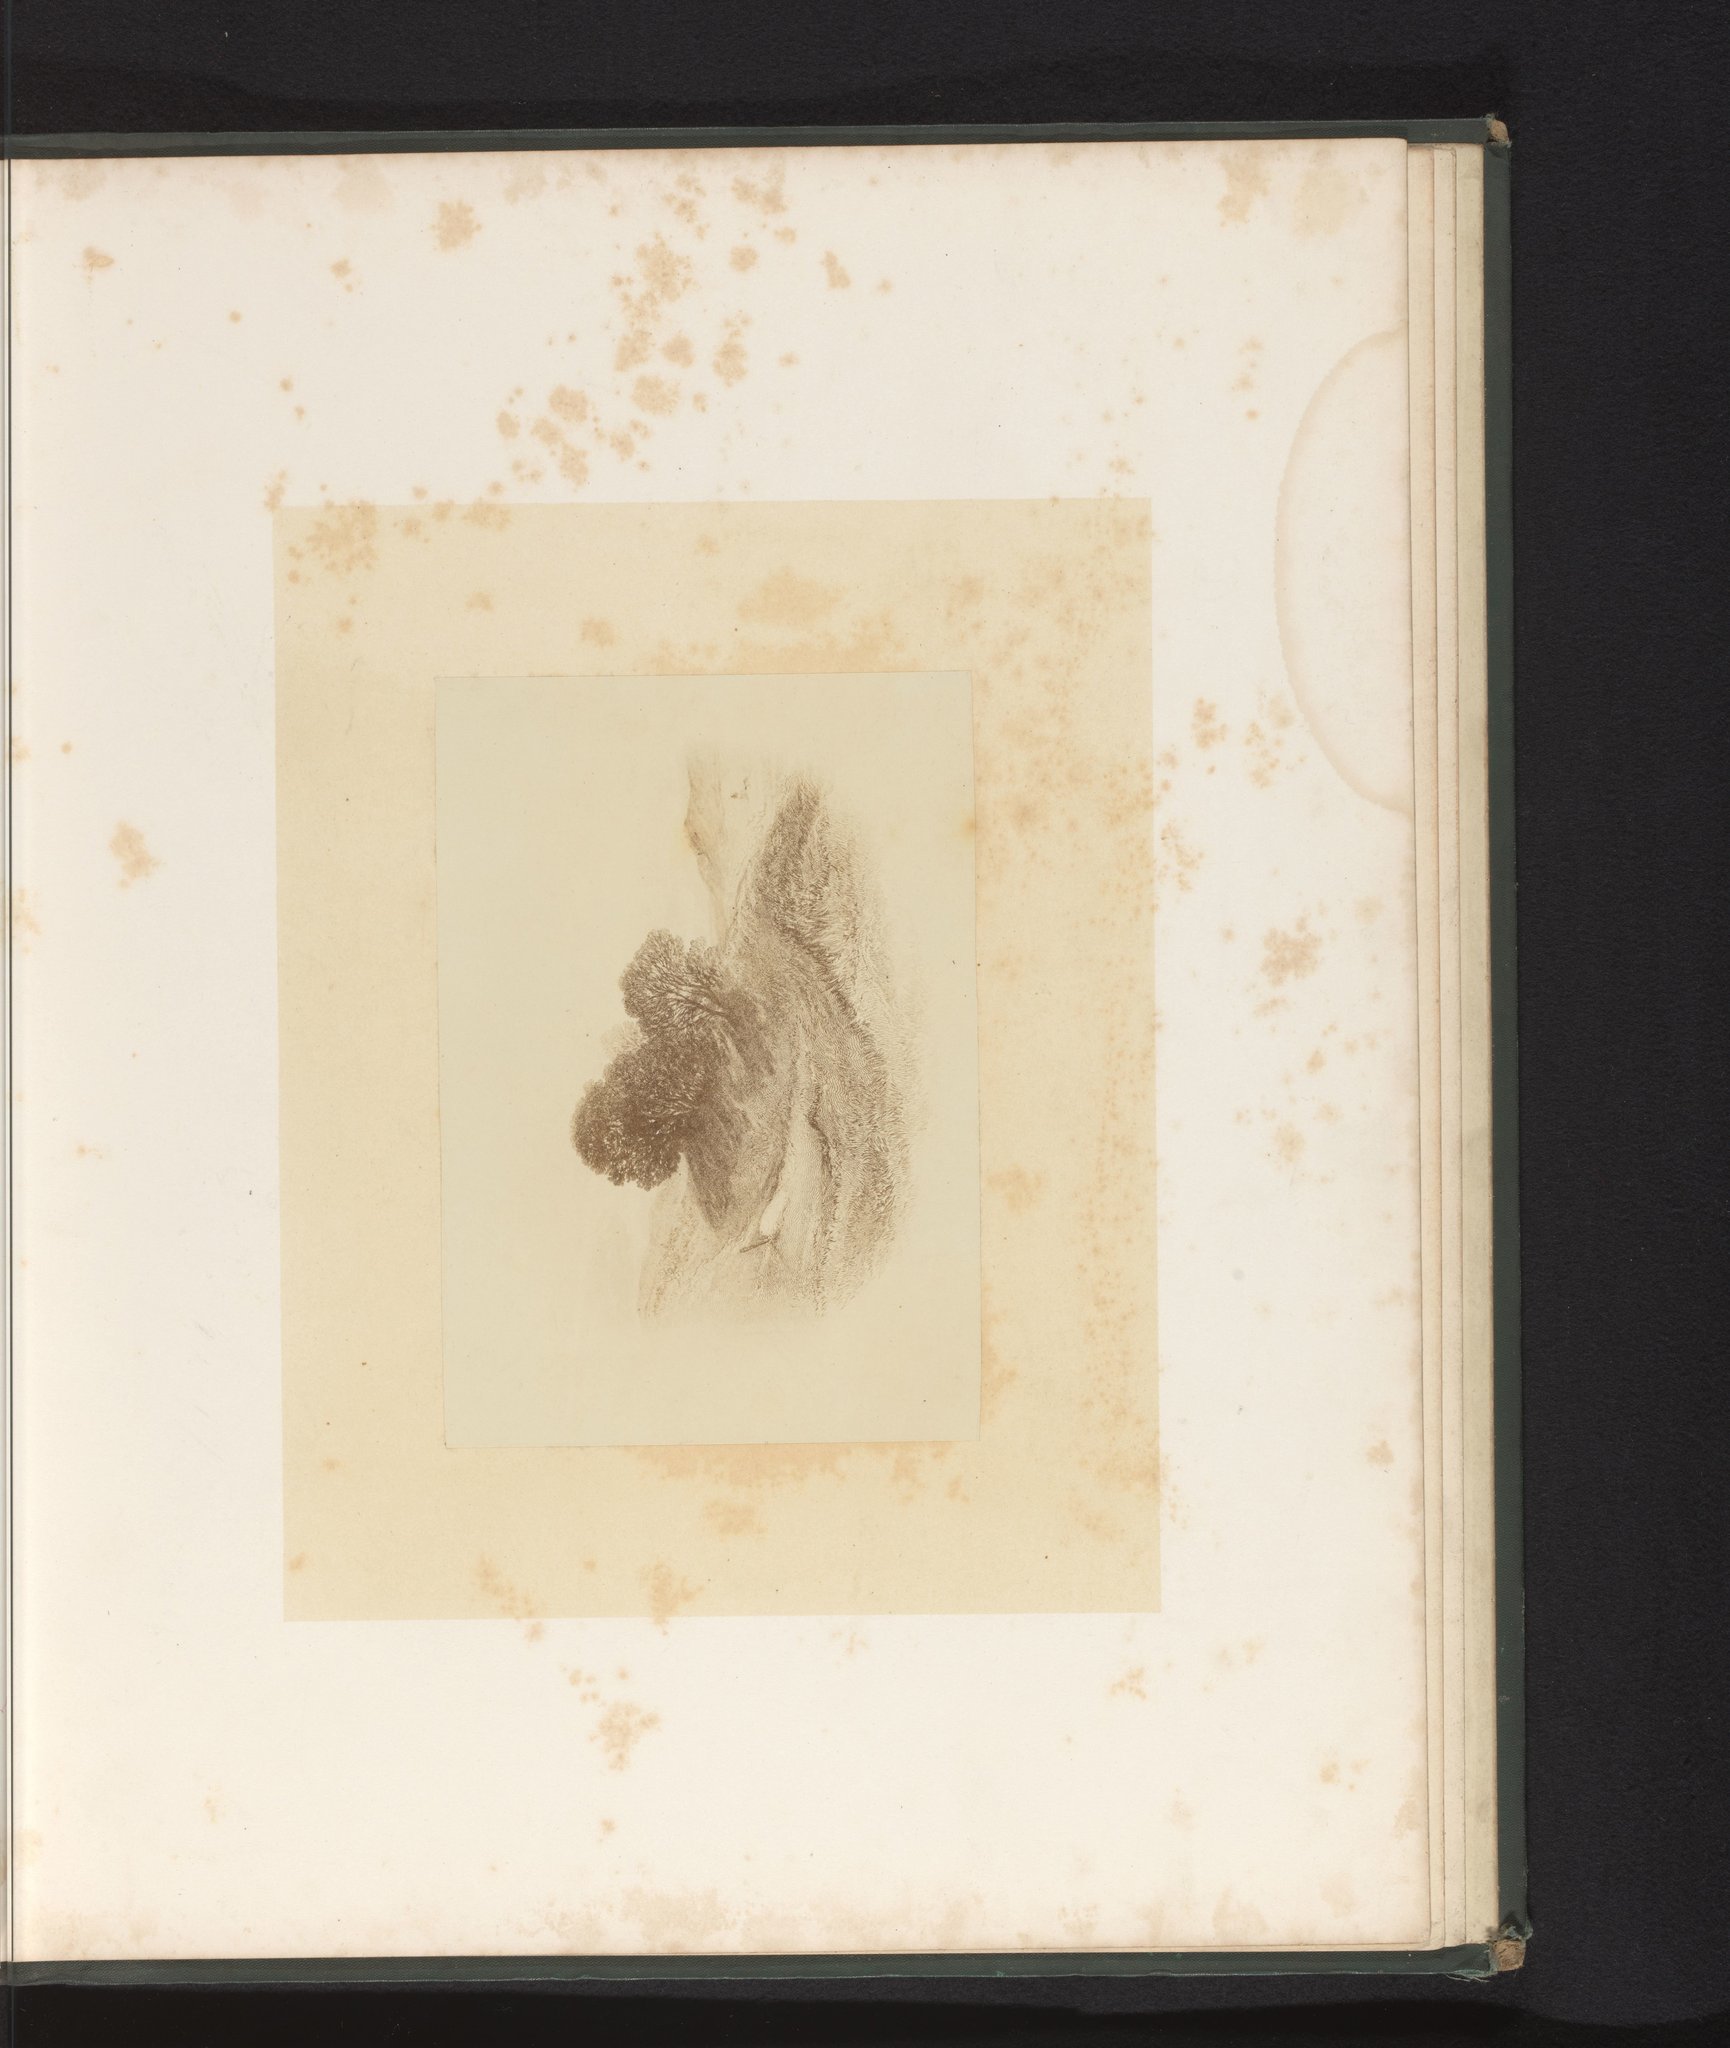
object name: reproduction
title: Fotoreproductie van een gravure van Rab's Grave, naar het ontwerp door Sir George Harvey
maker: thomas annan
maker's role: fotograaf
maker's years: 1829-1887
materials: photographic support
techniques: albumen print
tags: grave, tomb